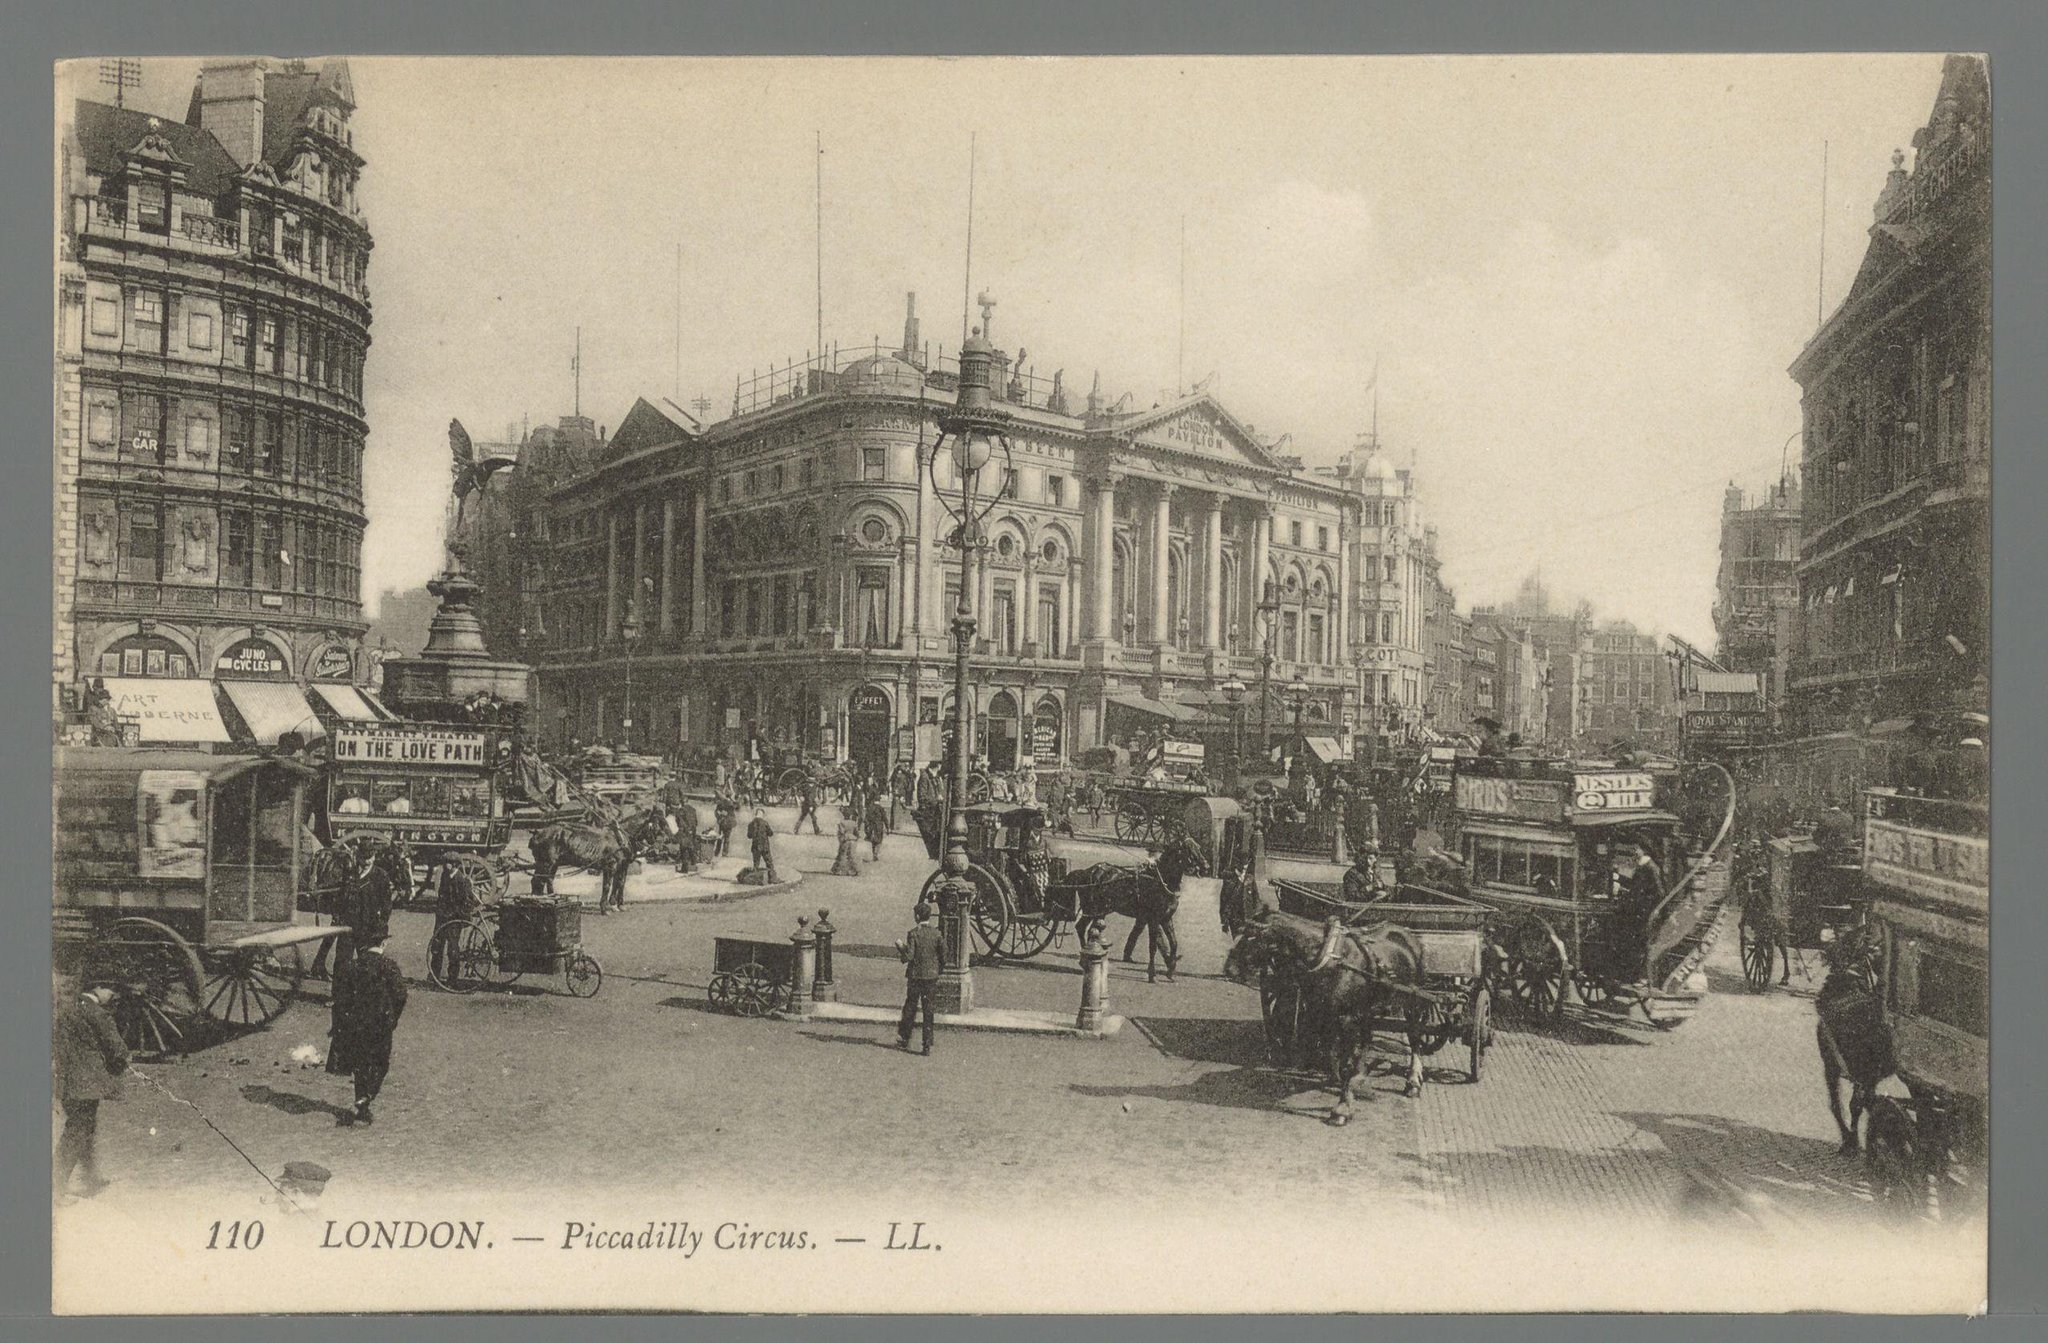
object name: photomechanical print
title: London. - Piccadilly Circus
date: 1902-1918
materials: cardboard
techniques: photograph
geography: london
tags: music-hall, street